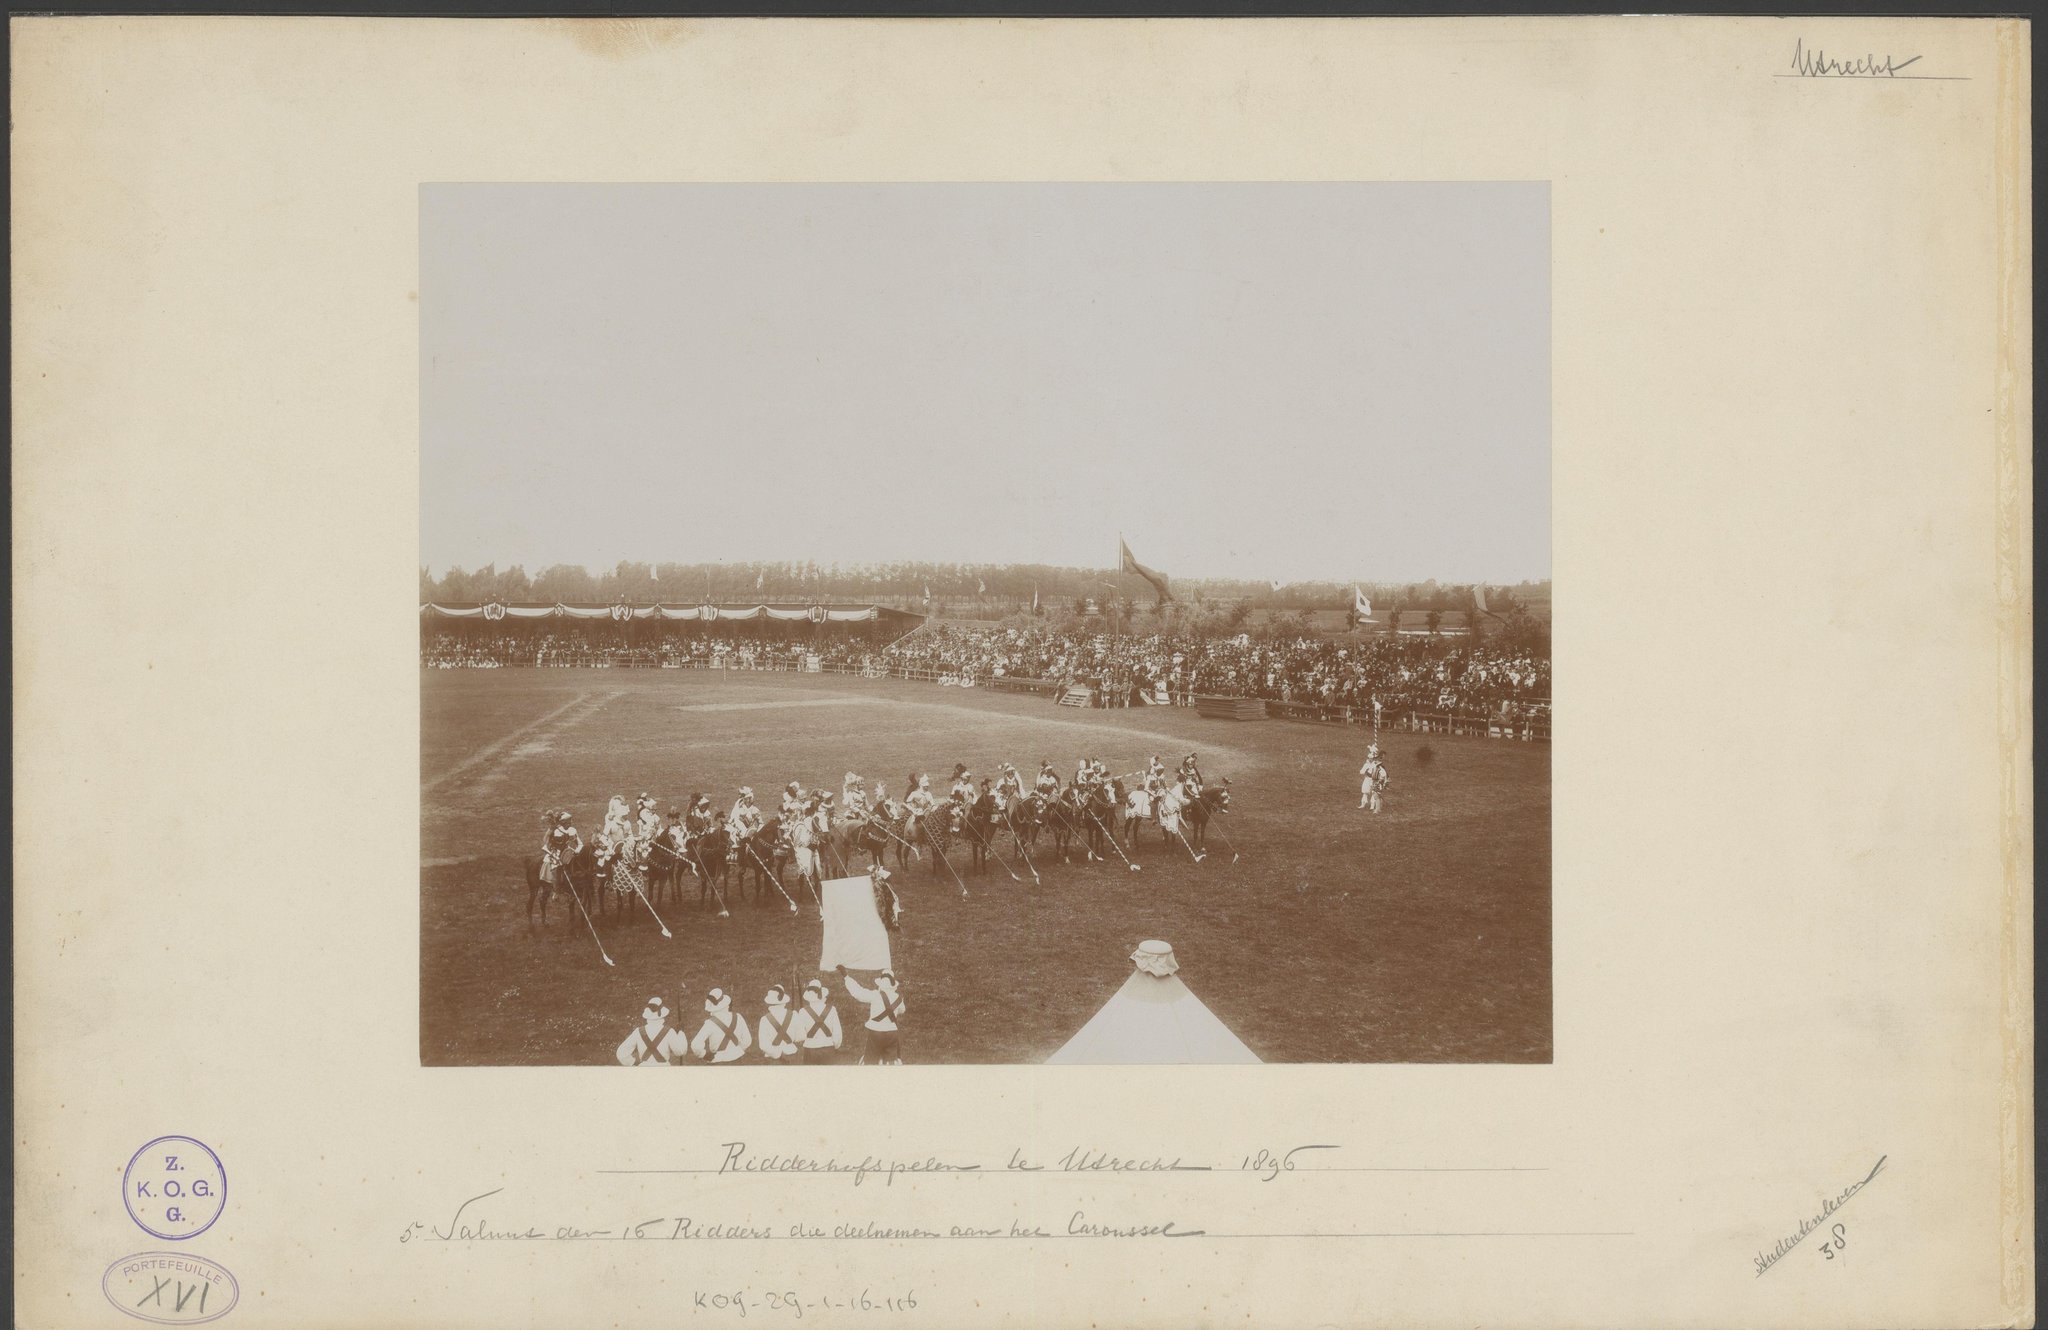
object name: photograph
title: Saluut van de ridders die deelnemen aan de carrousel tijdens de Ridderhofspelen, 1896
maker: Anonymous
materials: paper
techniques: albumen print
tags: tournament, (medieval) fighting contest, triumphal entry and public reception, pageant, 'entrée solennelle', 'joyeuse entrée', public festivities, horse, utrecht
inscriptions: collector's mark: Lugt 1641, stamp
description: Saluut van de ridders die deelnemen aan de carrousel tijdens de Ridderhofspelen. De Ridderhofspelen werden gehouden tussen 24 en 26 juni 1896 in Utrecht. Onderwerpsrubrieken binnen de Atlas Zeden en Gewoonten: Onderwijs en Wetenschappen, Studentenleven.